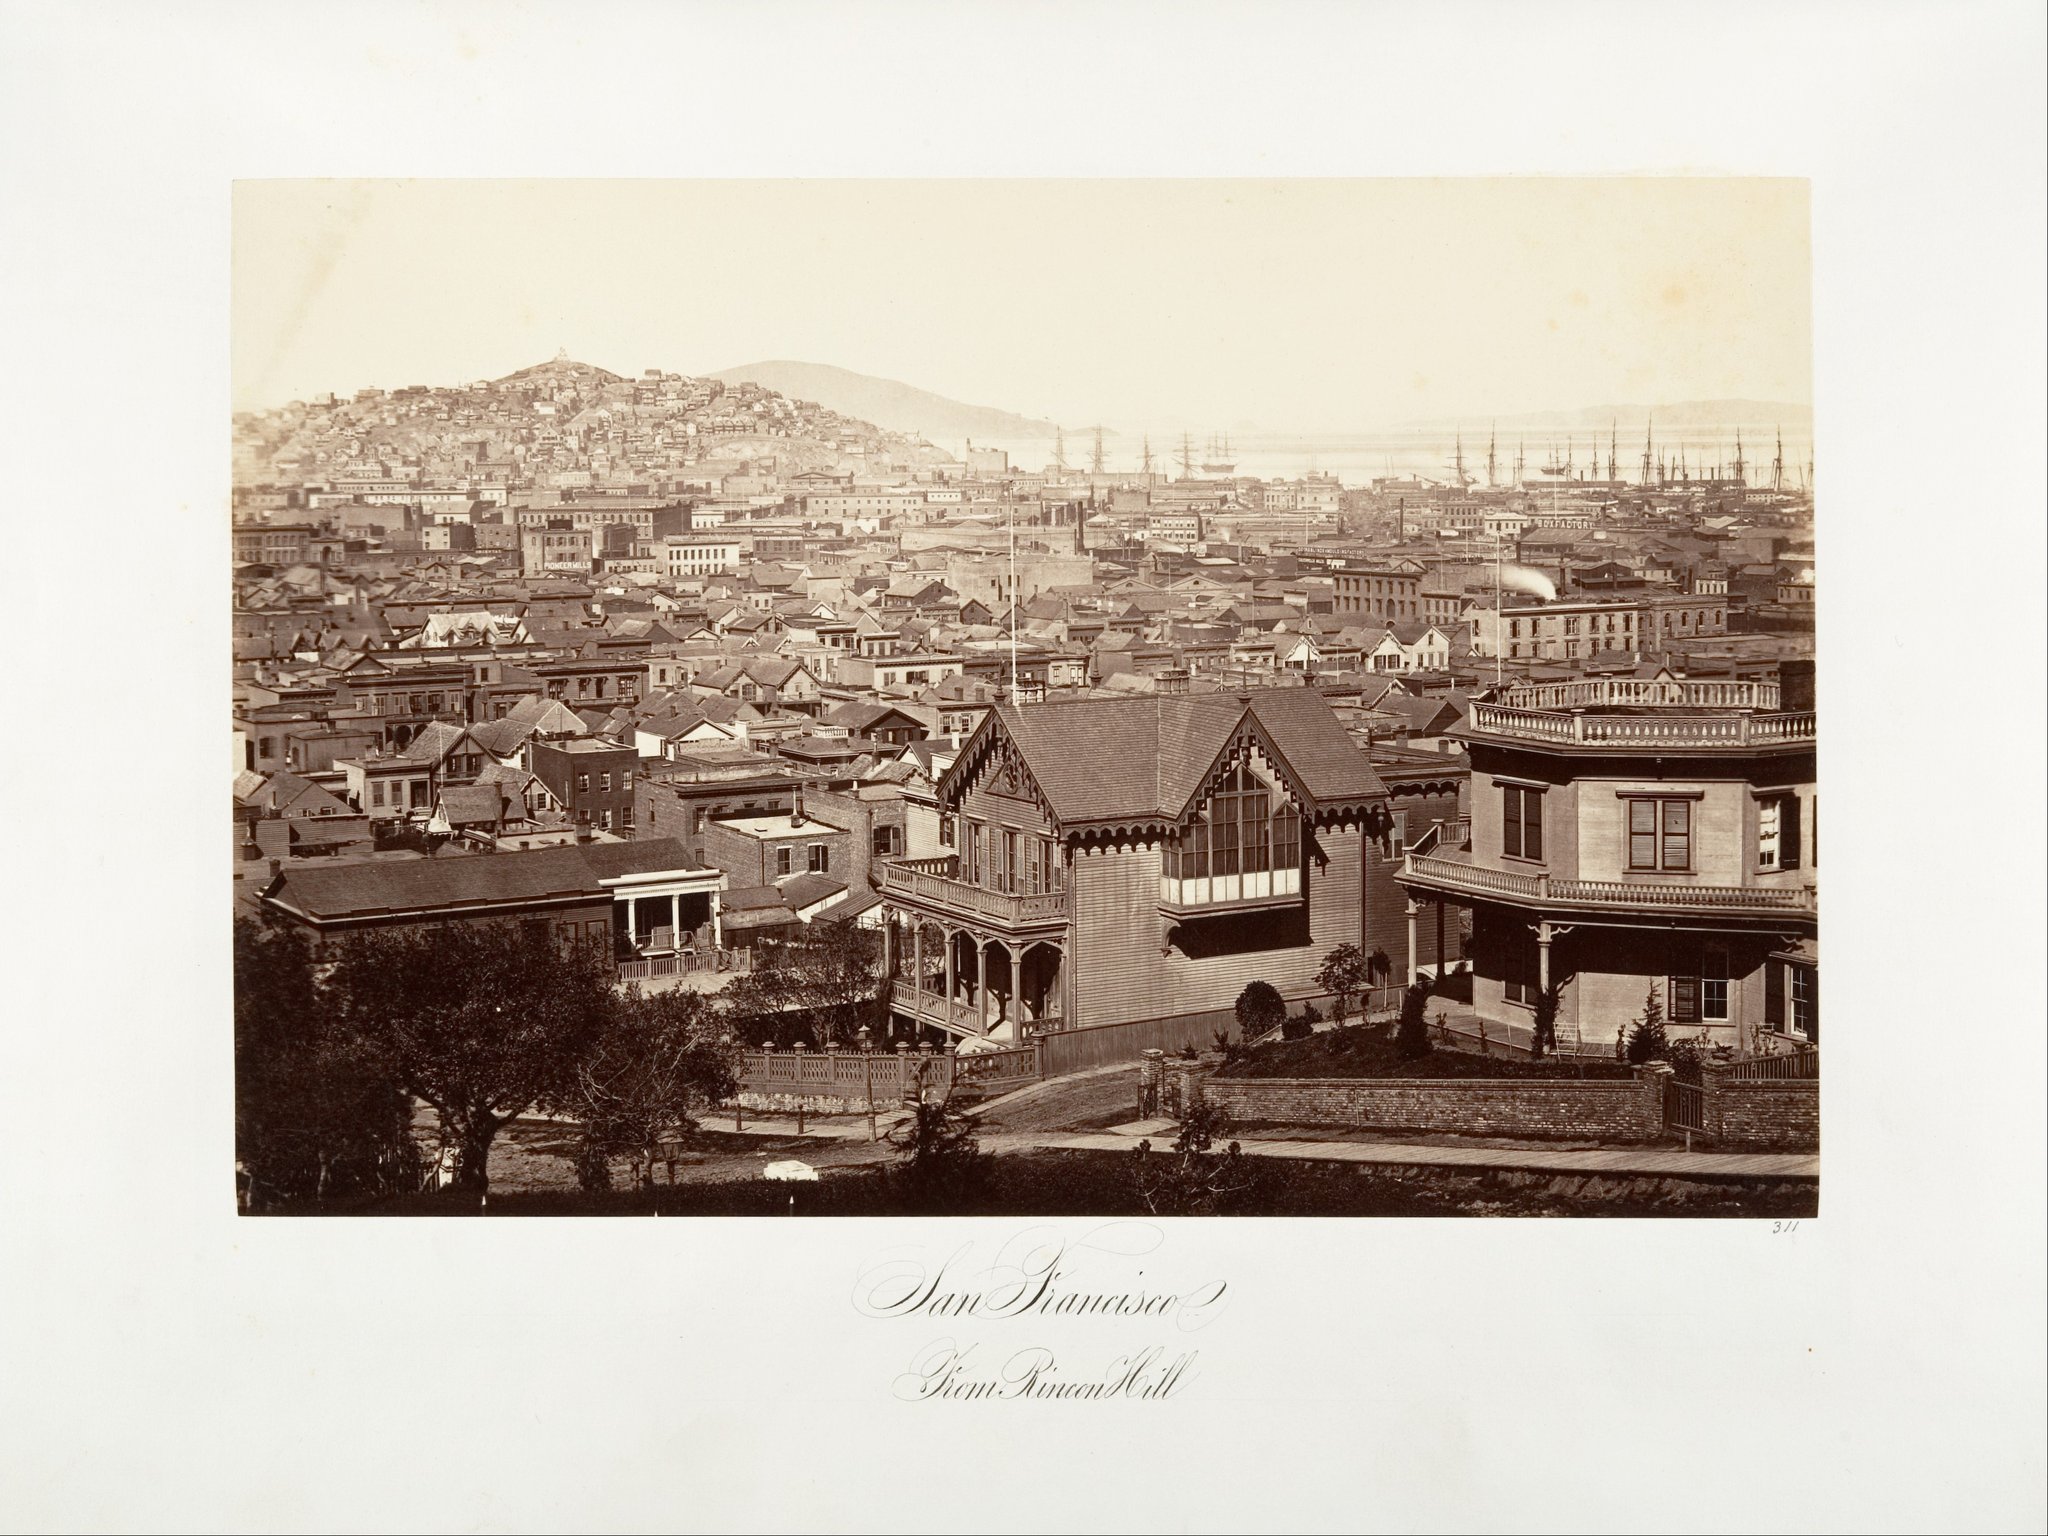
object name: photograph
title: San Francisco, from Rincon Hill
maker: carleton e. watkins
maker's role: artist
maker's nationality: american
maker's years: 1829-1916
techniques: albumen silver print, glass negative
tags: cities